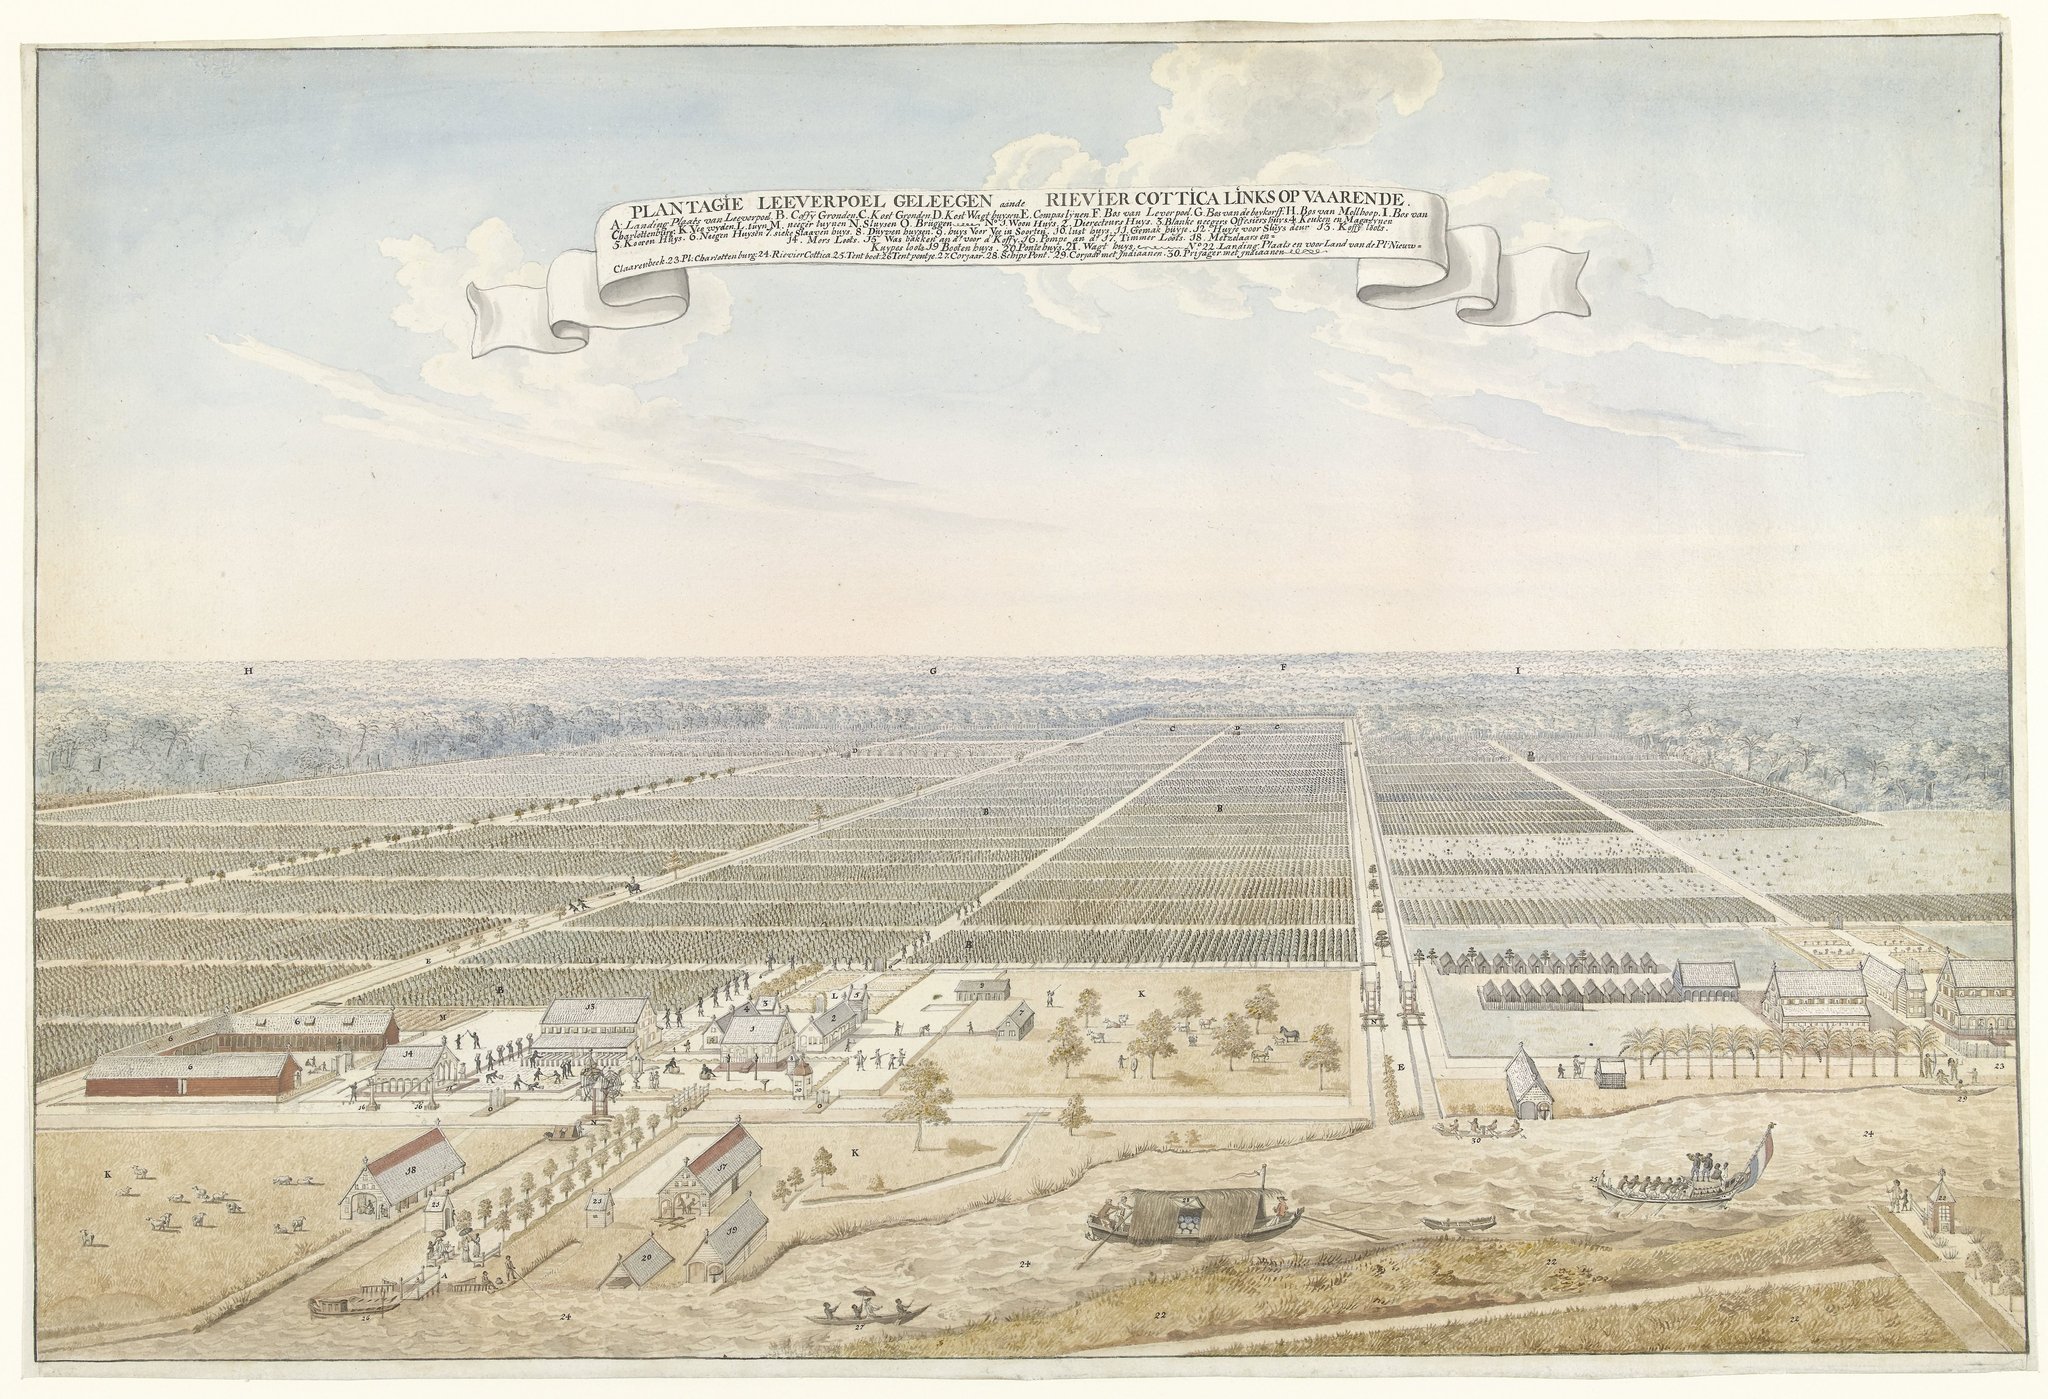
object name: watercolor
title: Plantagie Leeverpoel Geleegen Rievier Cottica linksop vaarende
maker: Anonymous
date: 1700-1800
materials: ink, paper, pencil, watercolor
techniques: brush, pen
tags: plantation, coffee, tropical culture, suriname